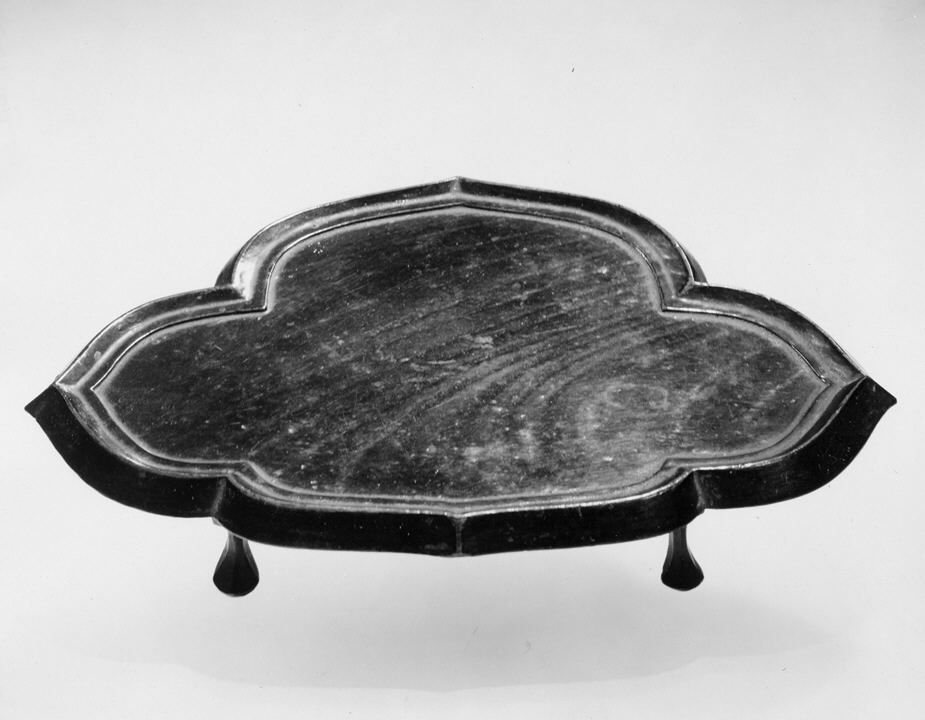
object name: stand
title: Three-Footed Stand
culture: japanese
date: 1301-1400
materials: wood